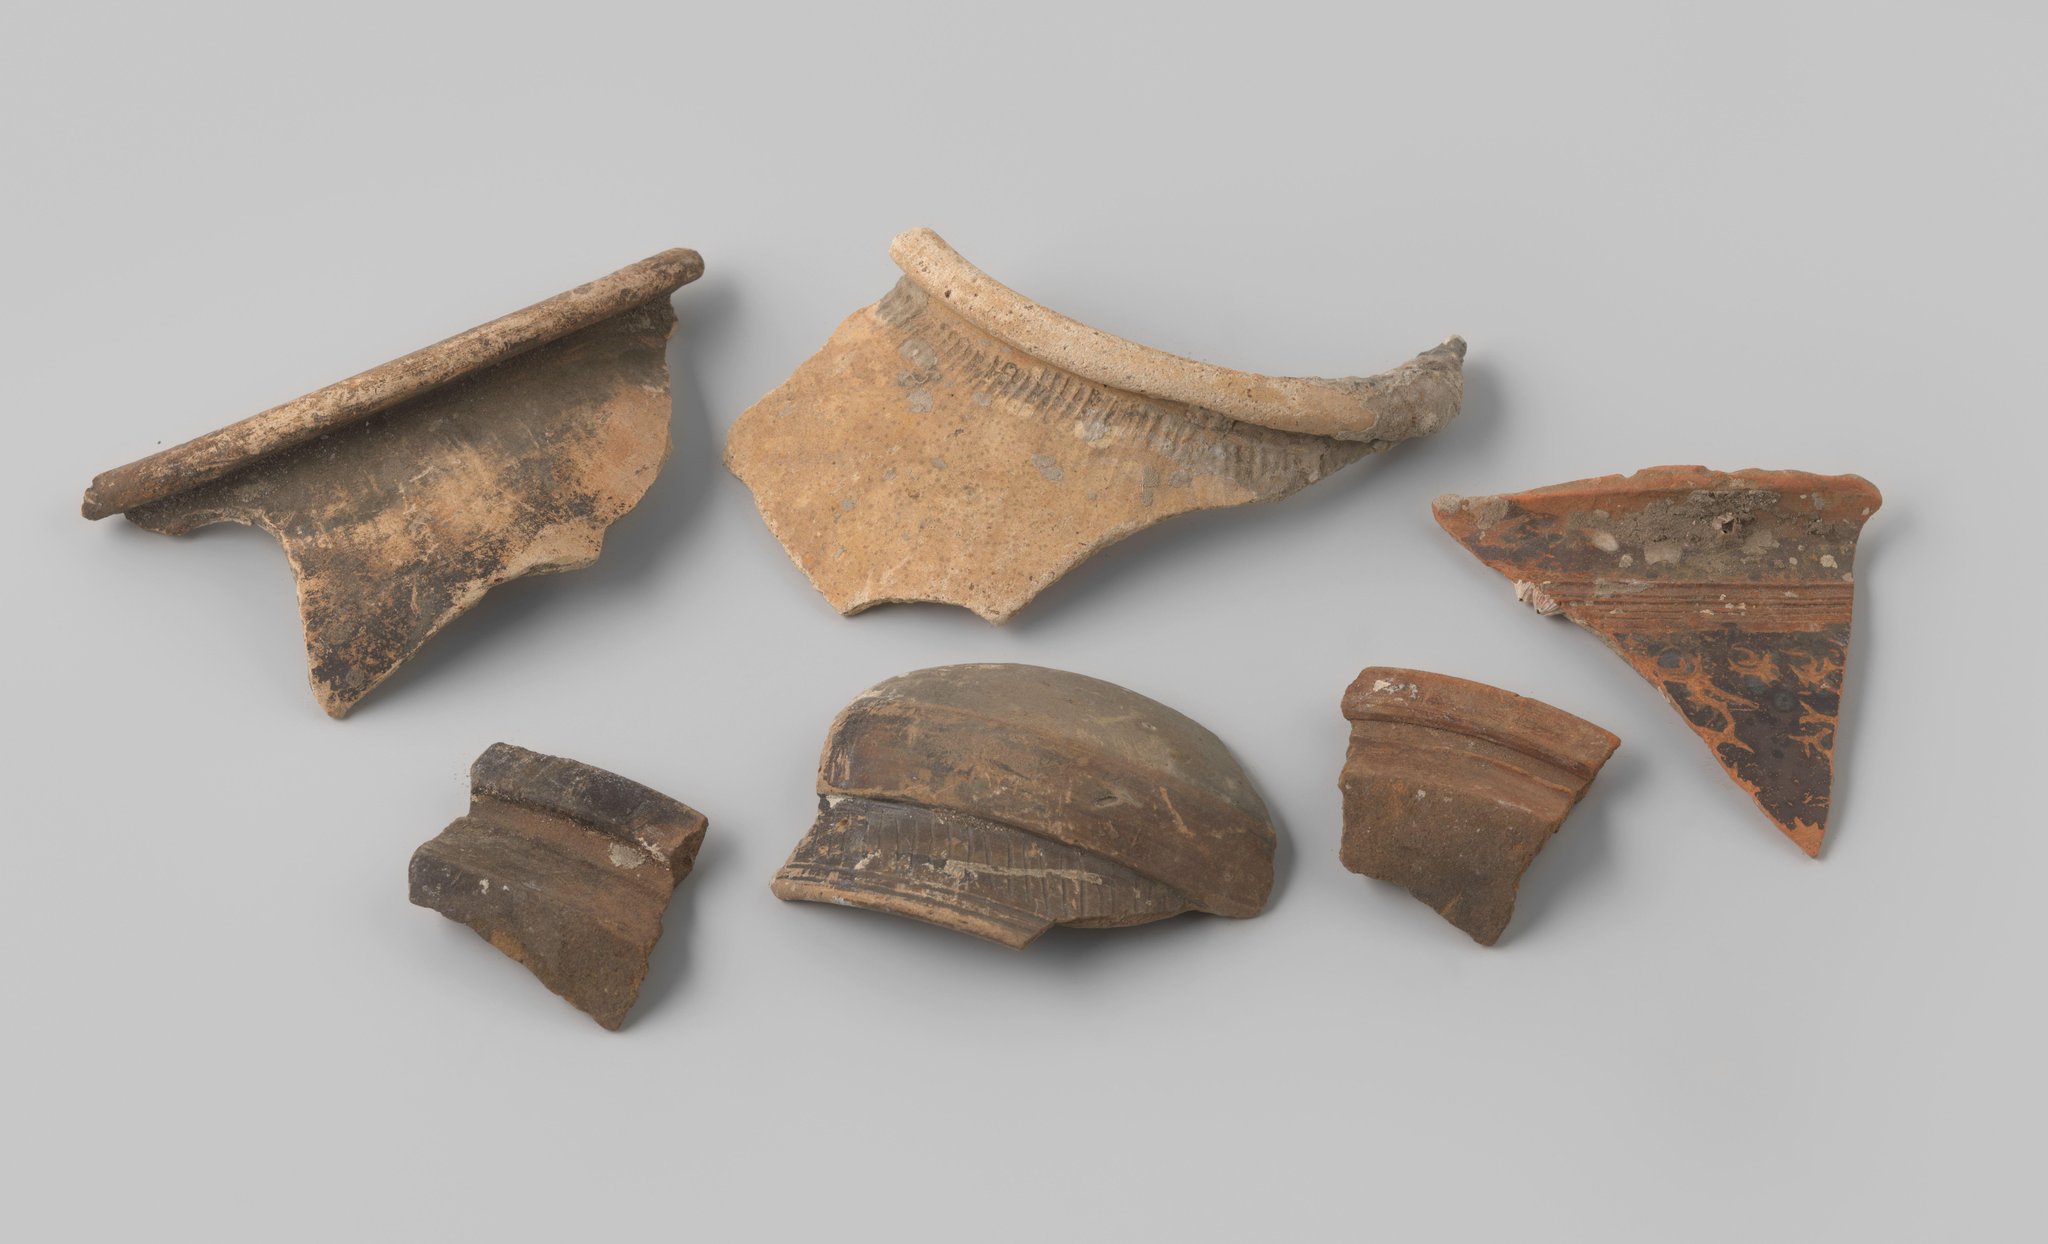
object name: sherd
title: Zak met scherven van roodbakkend aardewerk uit V.O.C.-schip de 'Witte Leeuw'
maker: Anonymous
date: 1613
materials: earthenware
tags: verenigde oostindische compagnie, sint-helena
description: Zak met scherven van roodbakkend aardewerk uit V.O.C.-schip de 'Witte Leeuw'.